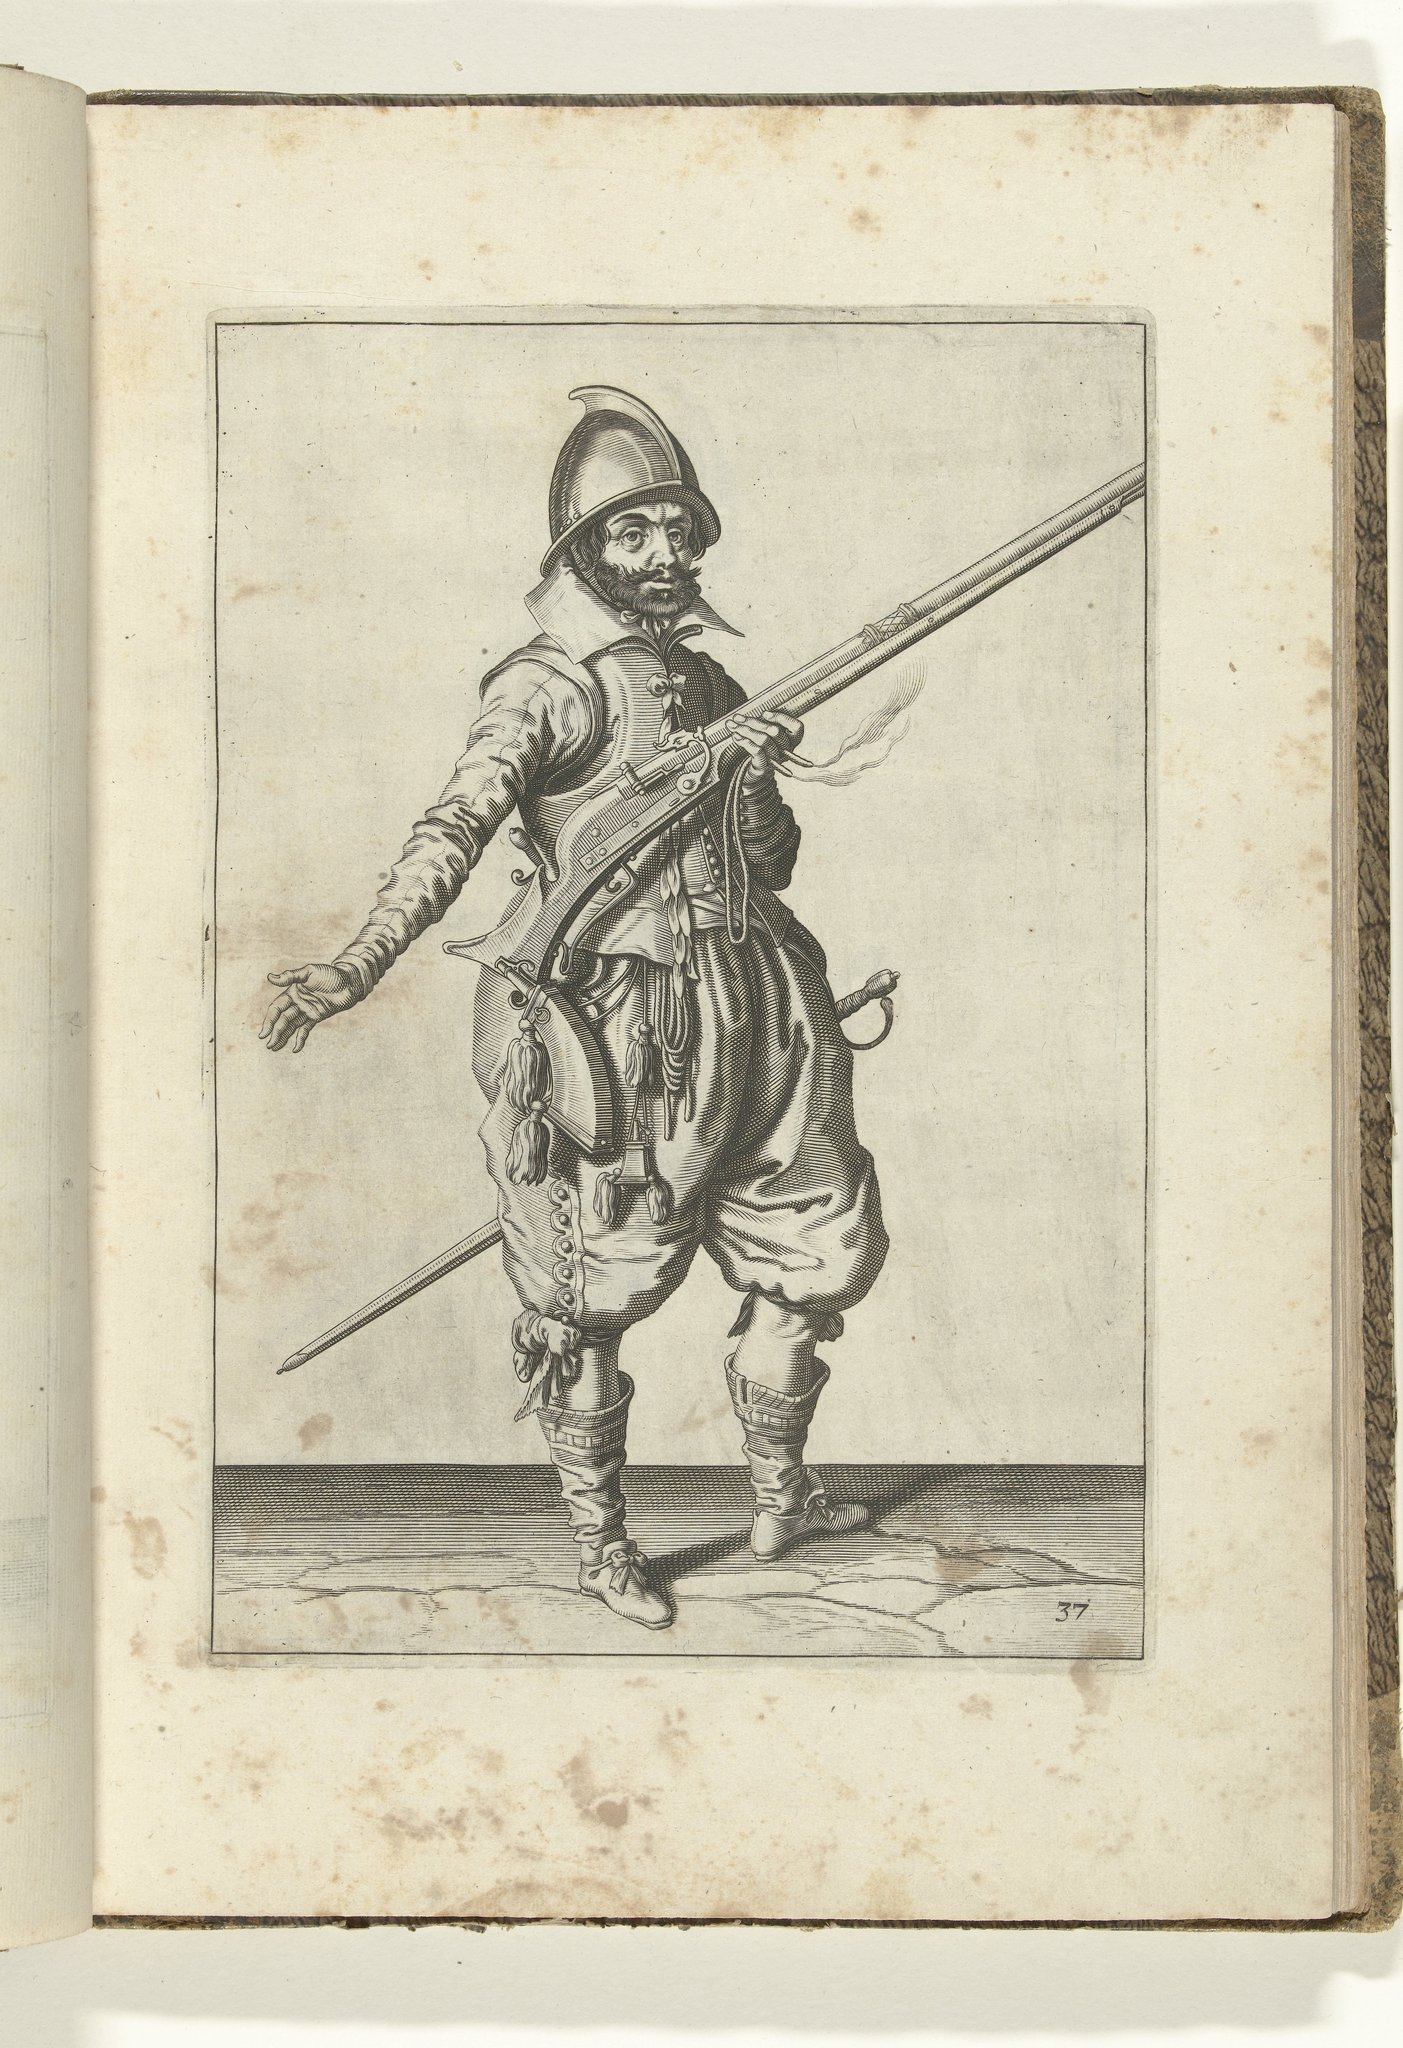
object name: print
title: Soldaat op wacht die zijn roer met zijn linkerhand bij zijn rechterzijde schuin omhoog gericht vasthoudt, zijn rechterhand uitgestoken (nr. 37), ca. 1600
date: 1597-1608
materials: paper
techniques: engraving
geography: amsterdam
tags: the hague, maurice (prince of orange), handling of weapons ~ military training, weapons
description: Een soldaat op wacht, ten voeten uit, naar rechts, die een roer (een bepaald type vuurwapen) met zijn linkerhand bij zijn rechterzijde vasthoudt, de loop schuin omhoog gericht (nr. 37), ca. 1600. In zijn linkerhand behalve het roer ook een brandende lont. Zijn rechterhand steekt hij uit. Plaat 37 in de instructies voor het hanteren van de roer: Brief enseignement, sur la representation des figures, du droit maniement de l'Harquebuse. Onderdeel van de illustraties in een Franse editie van J. de Gheyns Wapenhandelinghe: J. de Gheyn, Maniement d'armes, d'arquebuses, mousquetz et piques : en conformité de l'ordre de Mour le Prince Maurice, Prince d'Orange, Amsterdam 1608. Krijgswezen rond 1600.